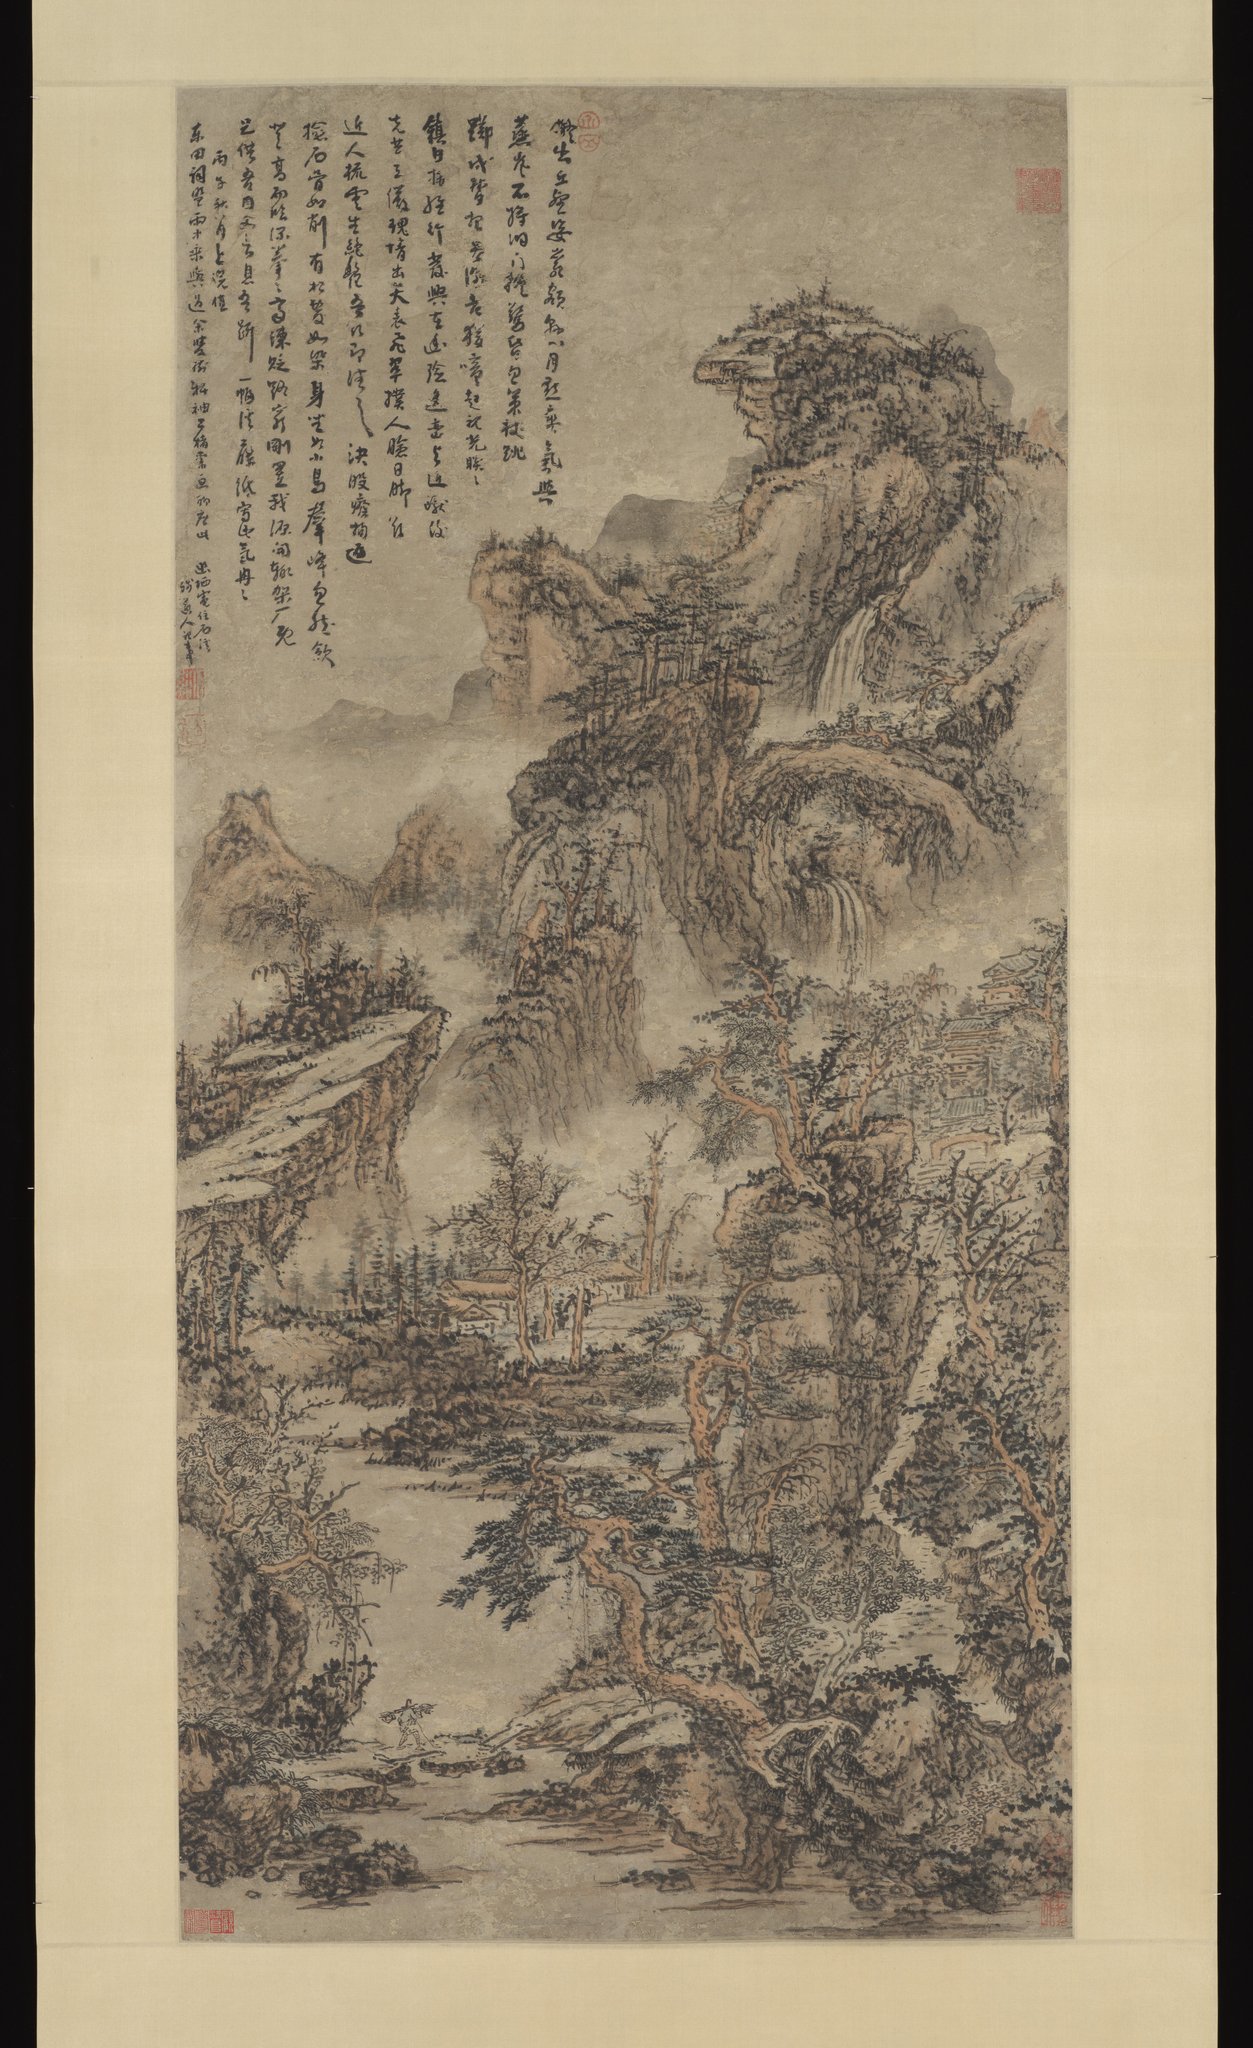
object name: hanging scroll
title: Wooded Mountains at Dusk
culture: chinese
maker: kuncan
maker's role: artist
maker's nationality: chinese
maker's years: 1612-1673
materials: ink, paper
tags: mountains,landscapes